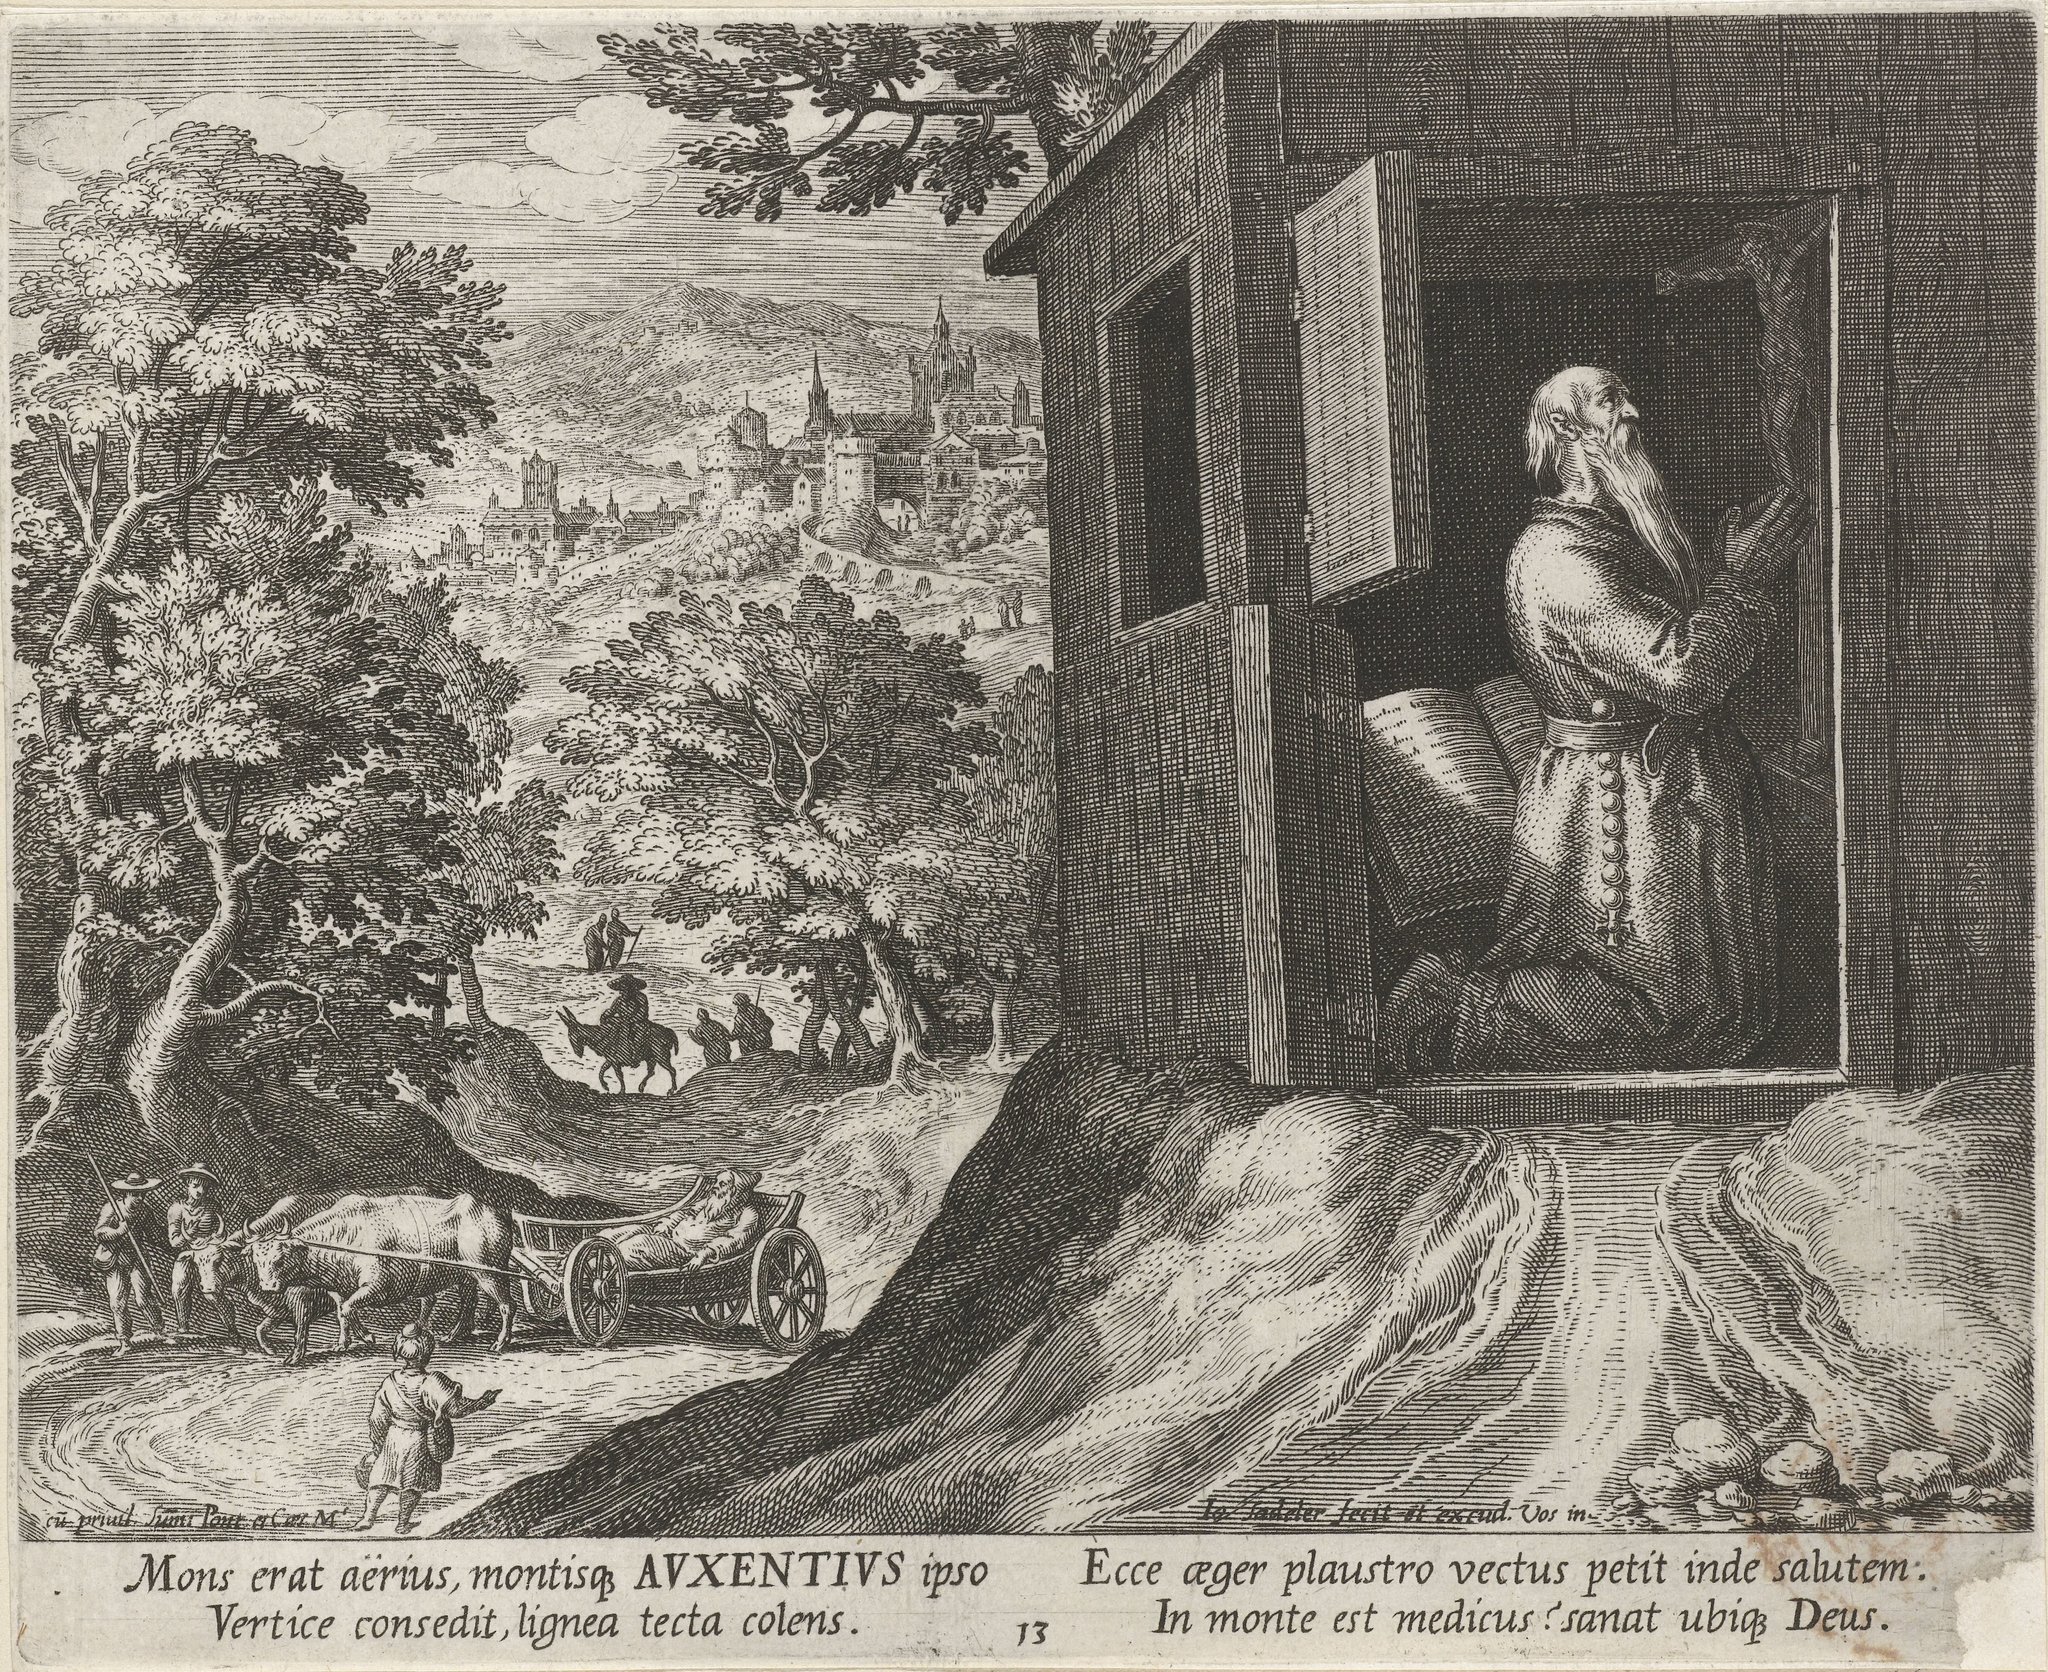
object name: print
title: Oraculum Anachoreticum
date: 1600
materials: paper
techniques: engraving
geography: venice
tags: hearse, funeral car, male saints (with name), forest, wood, anchorite, hermit, crucifix ~ personal devotion, one person praying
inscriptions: collector's mark: Lugt 240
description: Een boslandschap. Op de voorgrond de H. Auxentius van Syrië, een vroegchristelijke kluizenaar. Hij zit geknield voor een crucifix in zijn kluis en bidt. Op de achtergrond trekken twee ossen een kar met het lijk van de H. Auxentius.